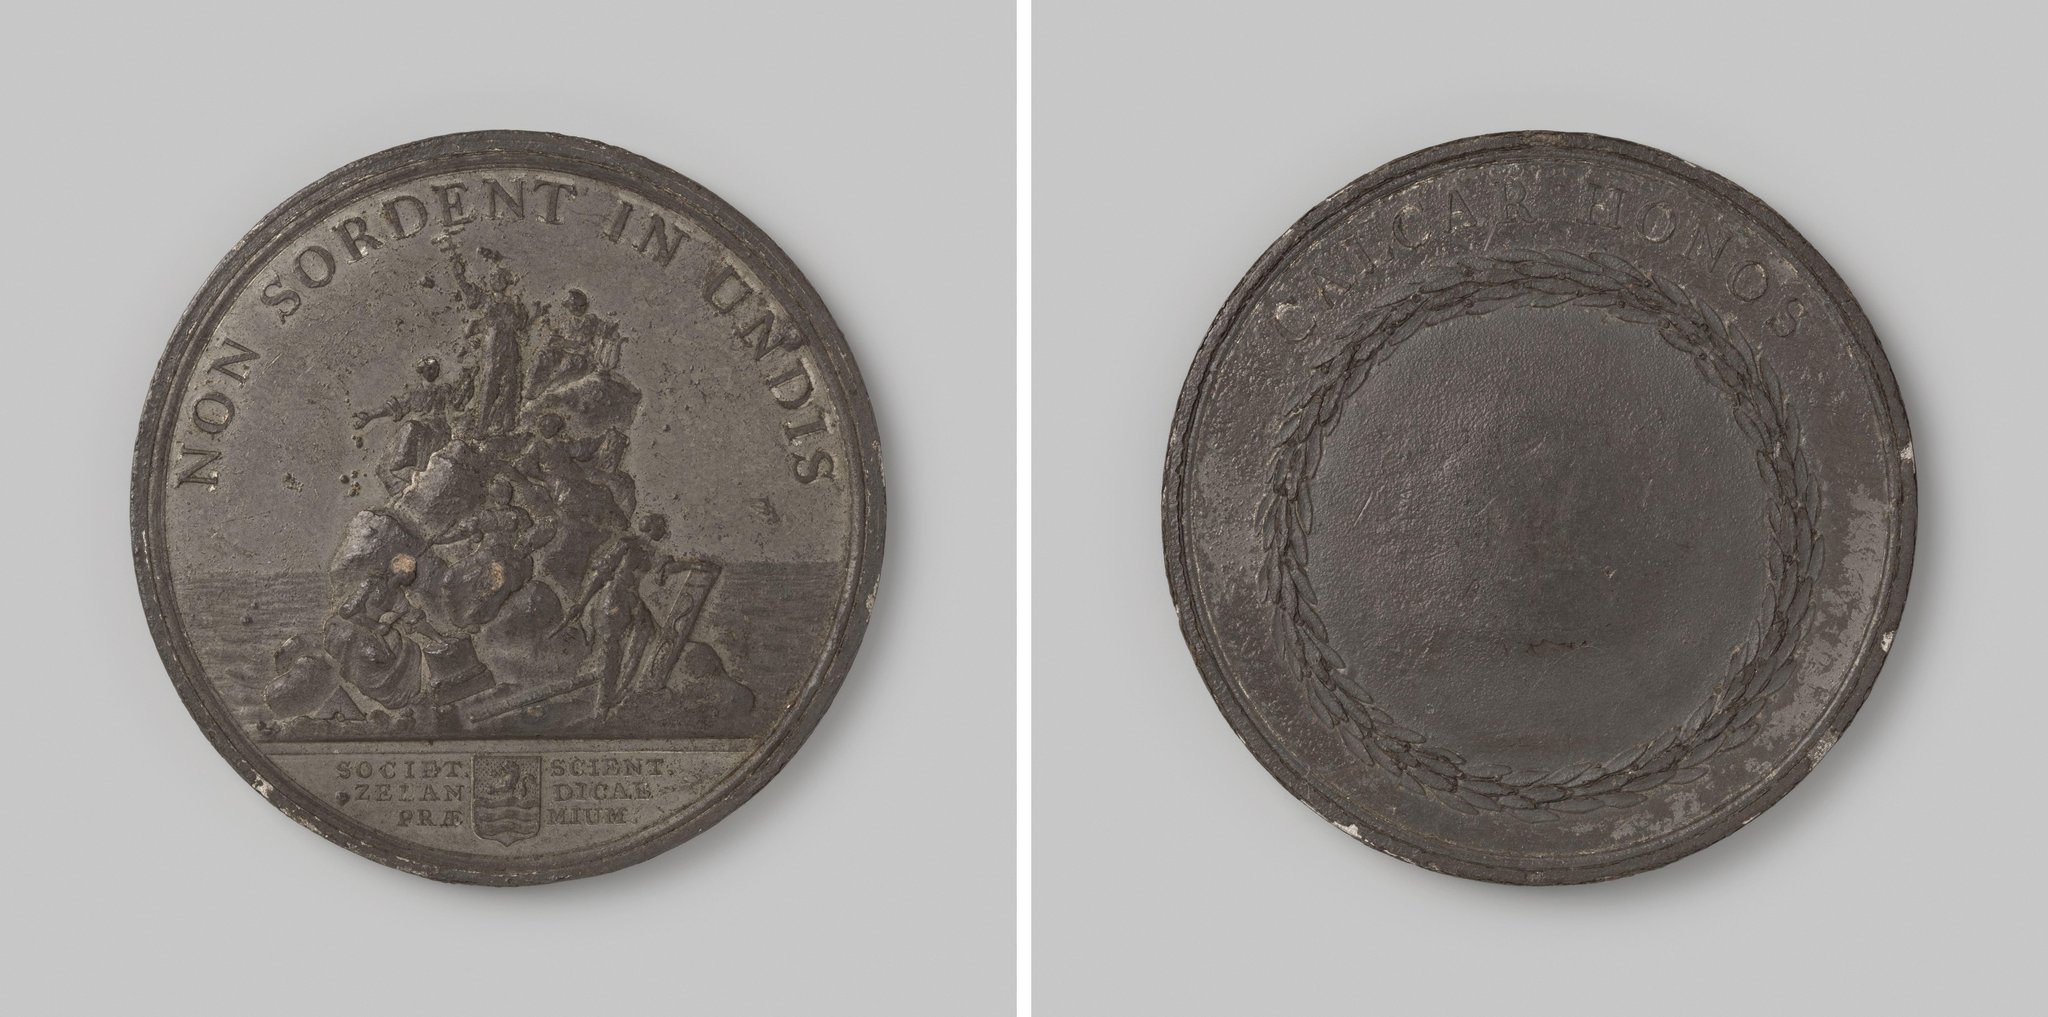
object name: history medal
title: Prijspenning van het Zeeuws Genootschap van Wetenschappen, afgieting in tin zonder inscriptie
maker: barend christiaan van calker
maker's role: medailleur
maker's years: 1739-1813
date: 1769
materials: tin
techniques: striking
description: Tinnen penning, op de voorzijde de zeven Vrije Kunsten op een rots in zee, met omschrift en afsnedetekst, op de keerzijde een lauwerkrans met bovenaan een opschrift, de inscriptieruimte is ruw afgewerkt en wat bol.